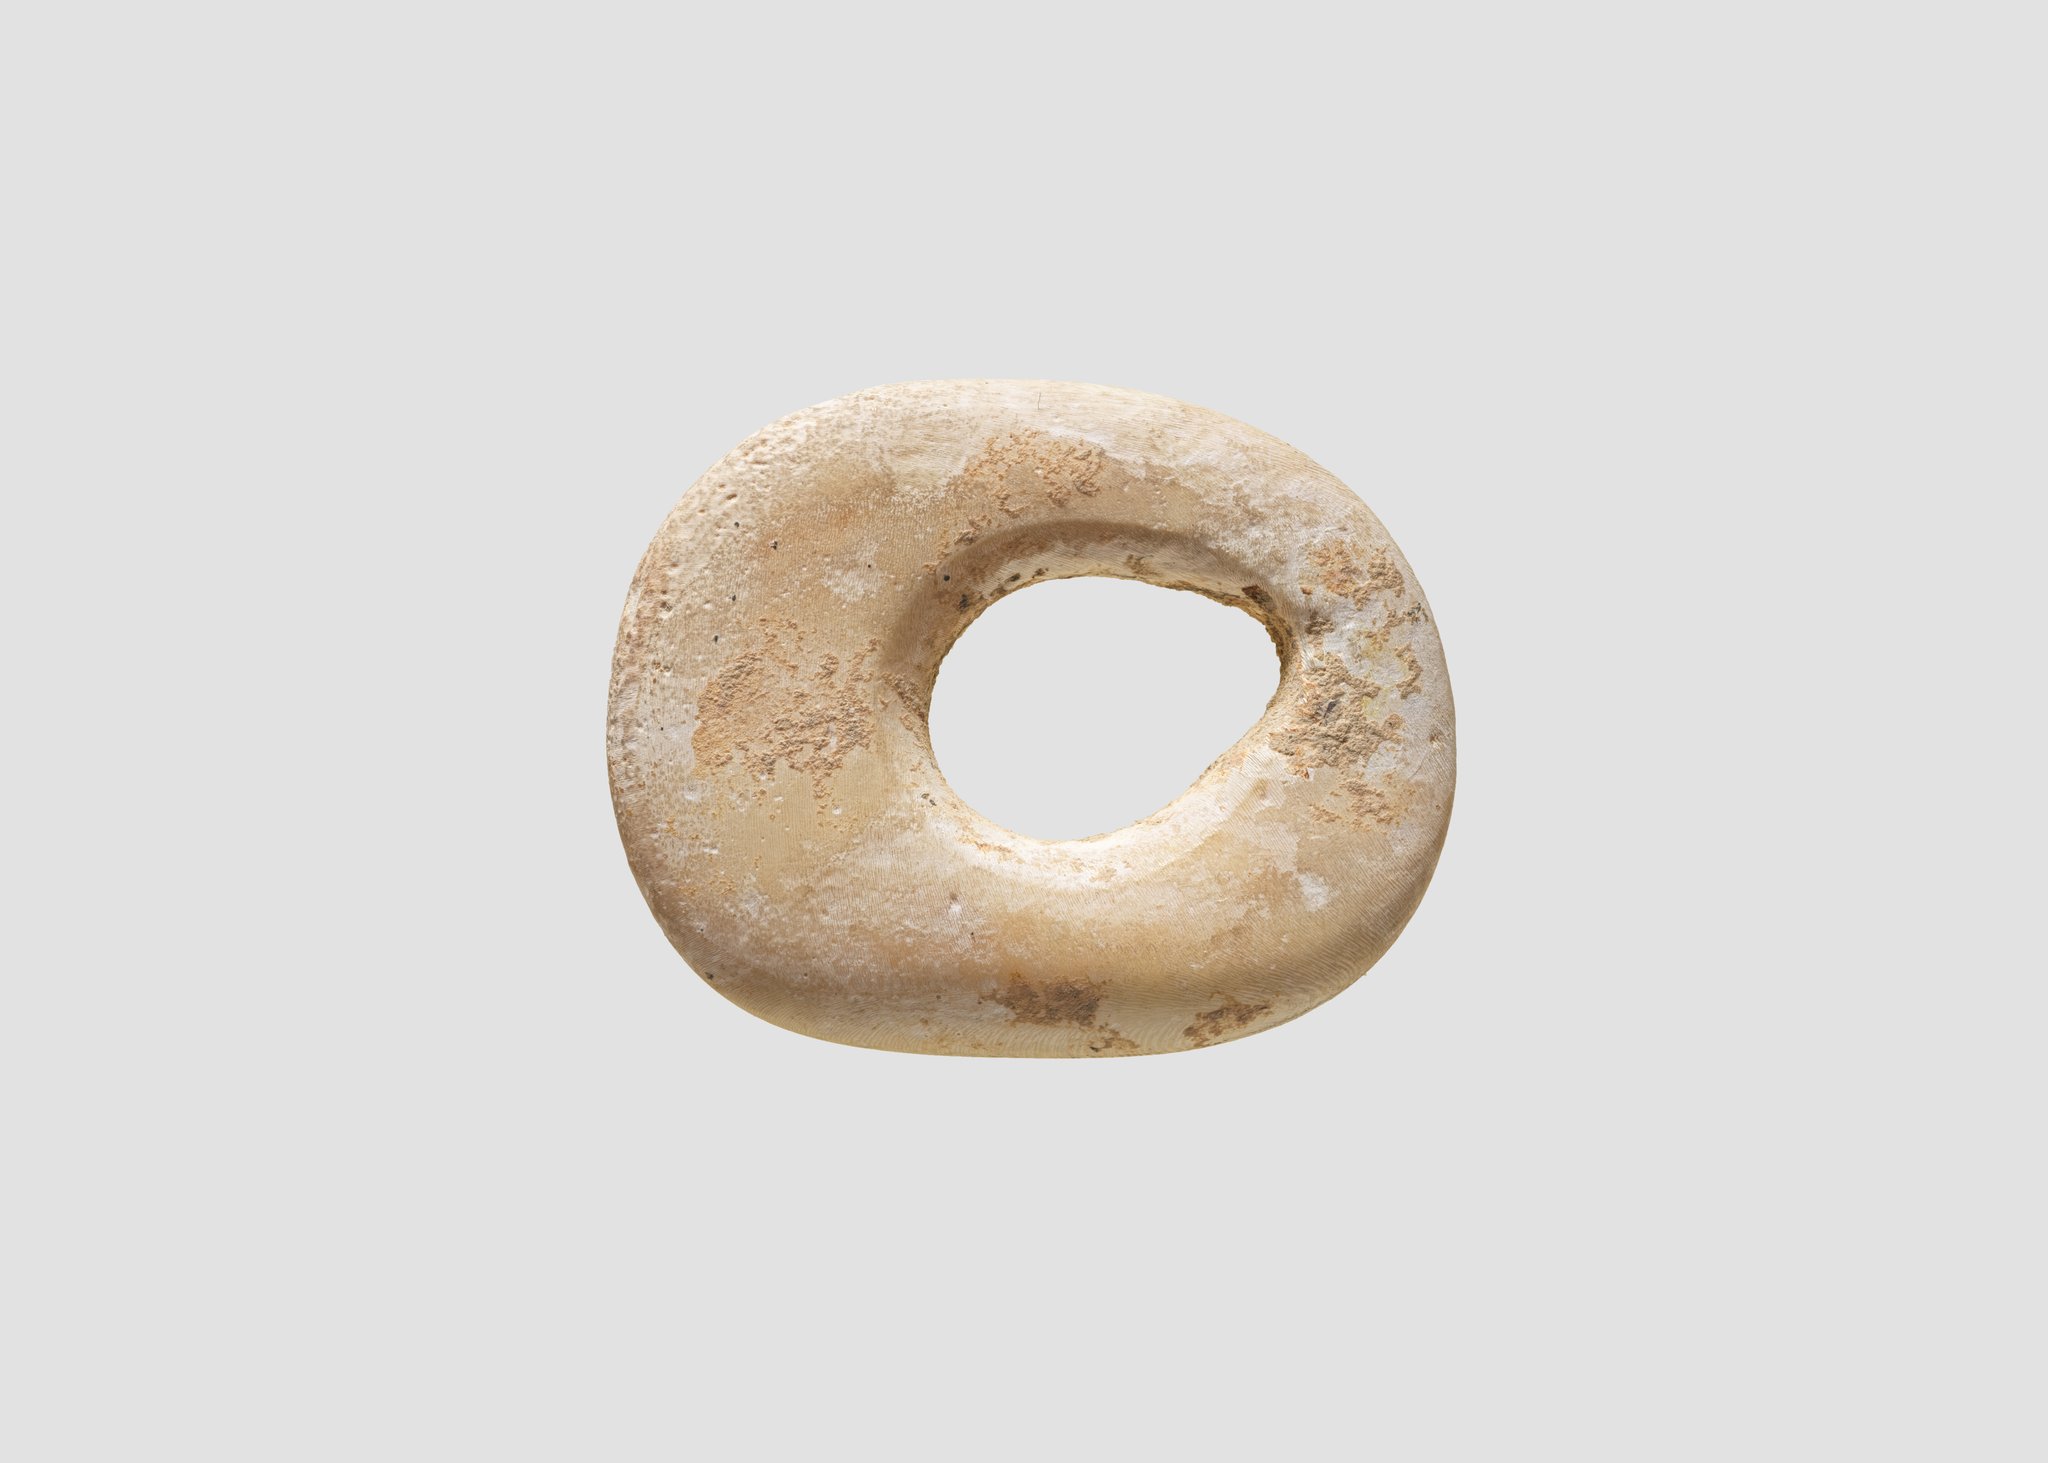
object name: ring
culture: sasanian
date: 201-700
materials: stone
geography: mesopotamia